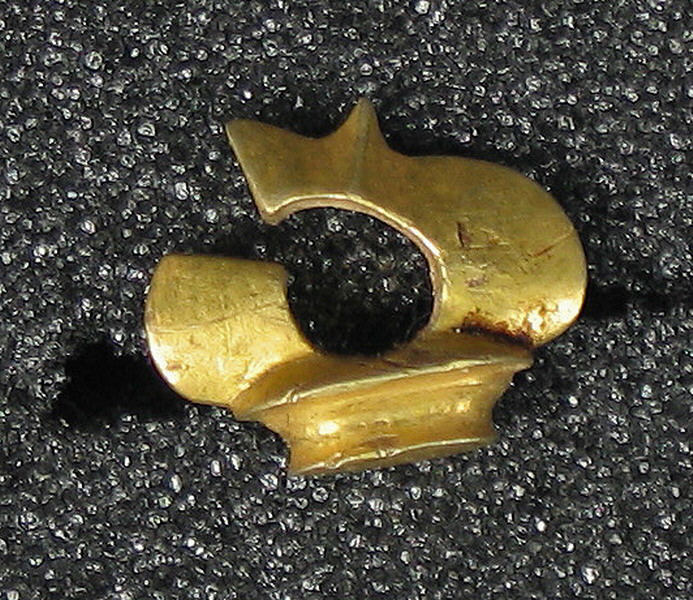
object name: earring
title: Cast Earring, Oval Centre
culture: indonesian, central java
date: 701-1200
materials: gold